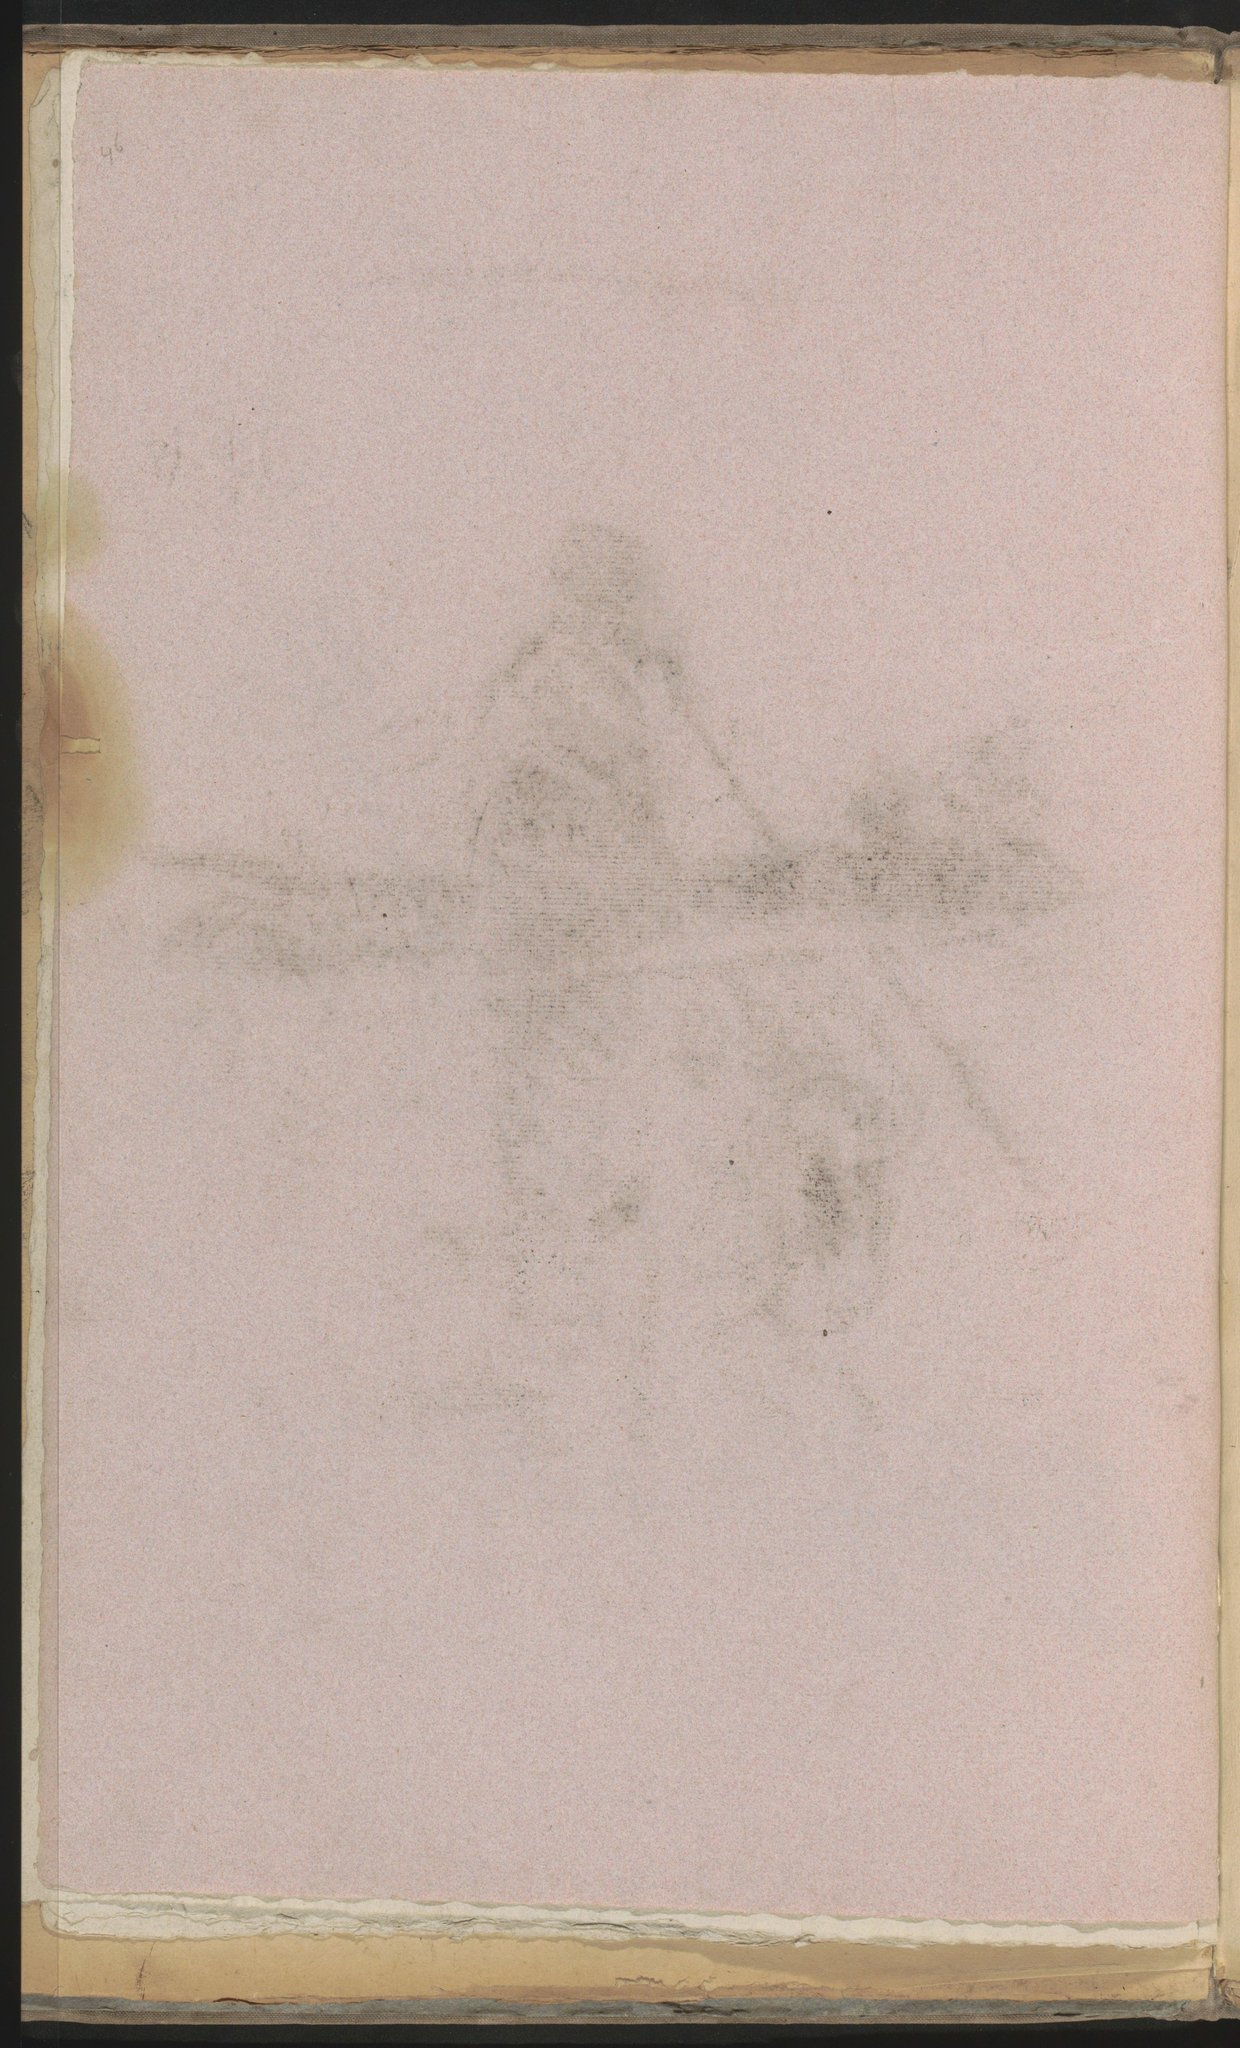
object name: sketchbook leaf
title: Abklatsch van de krijttekening op pagina 47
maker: willem witsen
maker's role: draughtsman, painter, print maker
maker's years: 1860-1923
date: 1884-1887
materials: paper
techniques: printmaking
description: Pagina 46 uit een schetsboek met 42 bladen vervaardigd rond de Ewijkshoeve.